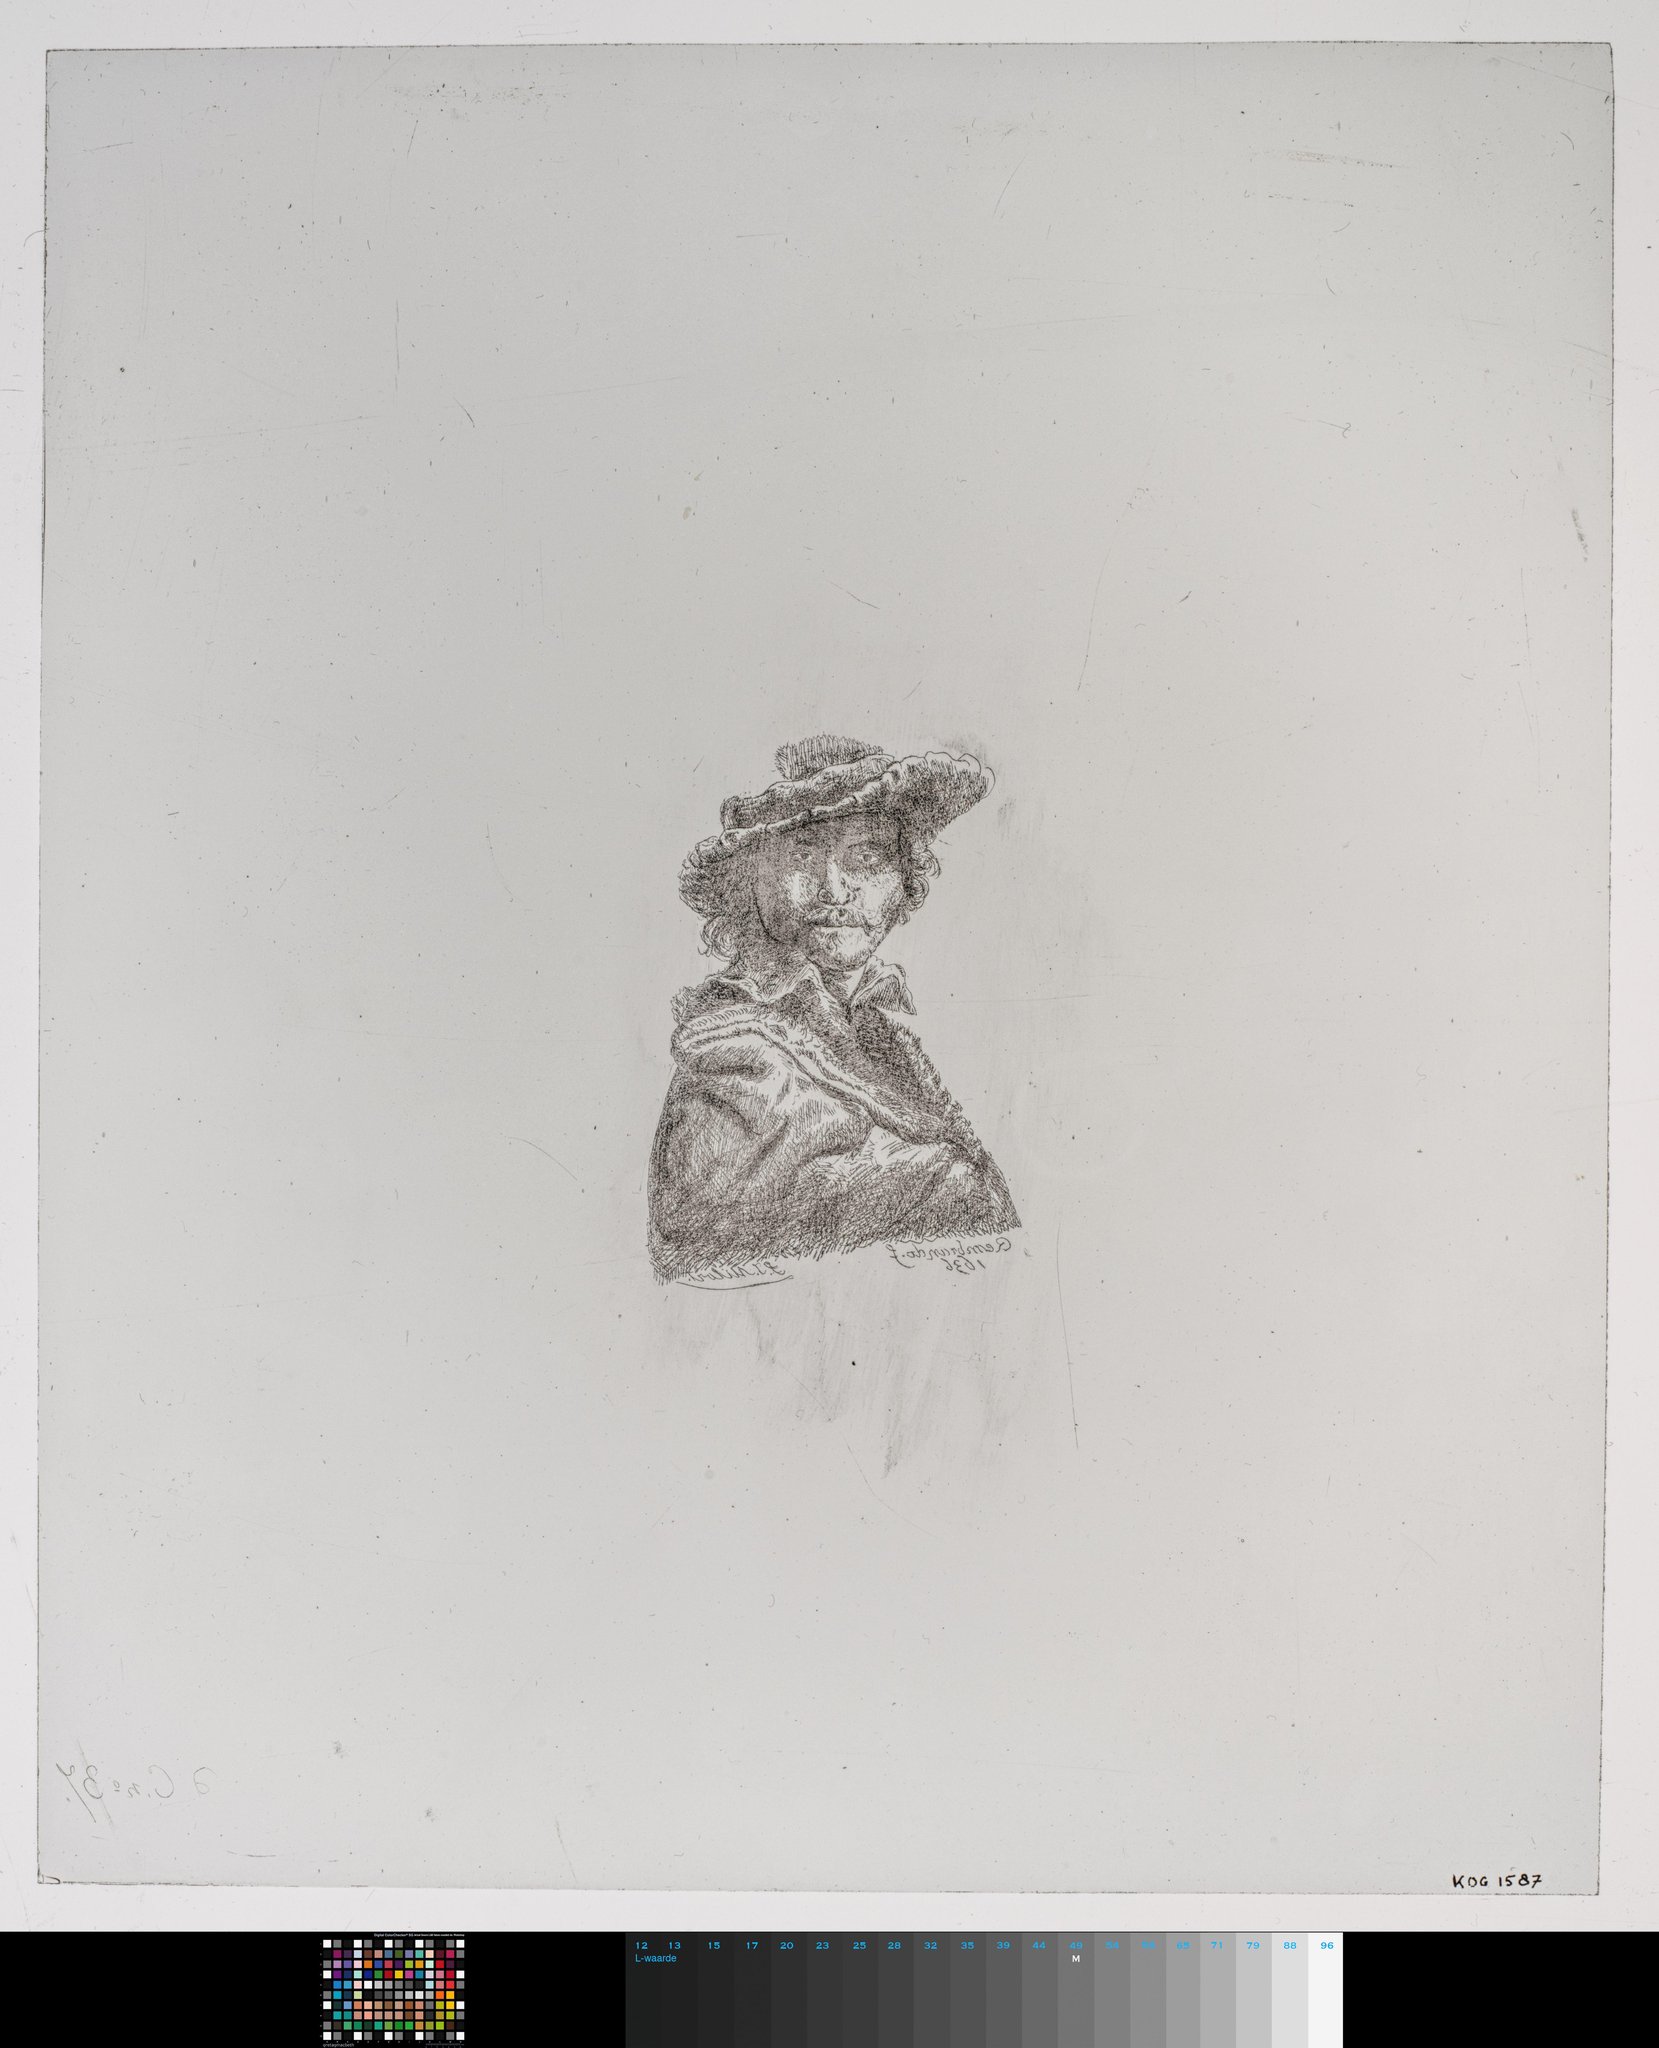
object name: light window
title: Ruit met een portret van Rembrandt.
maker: servatius johannes melort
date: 1850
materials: glass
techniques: diamond point engraving, engraving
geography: netherlands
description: Rechthoekige ruit, waarop is gegraveerd een portret van Rembrandt. Link onder het portret Rembrandt, f 1636, rechts onder S.J. Milort.